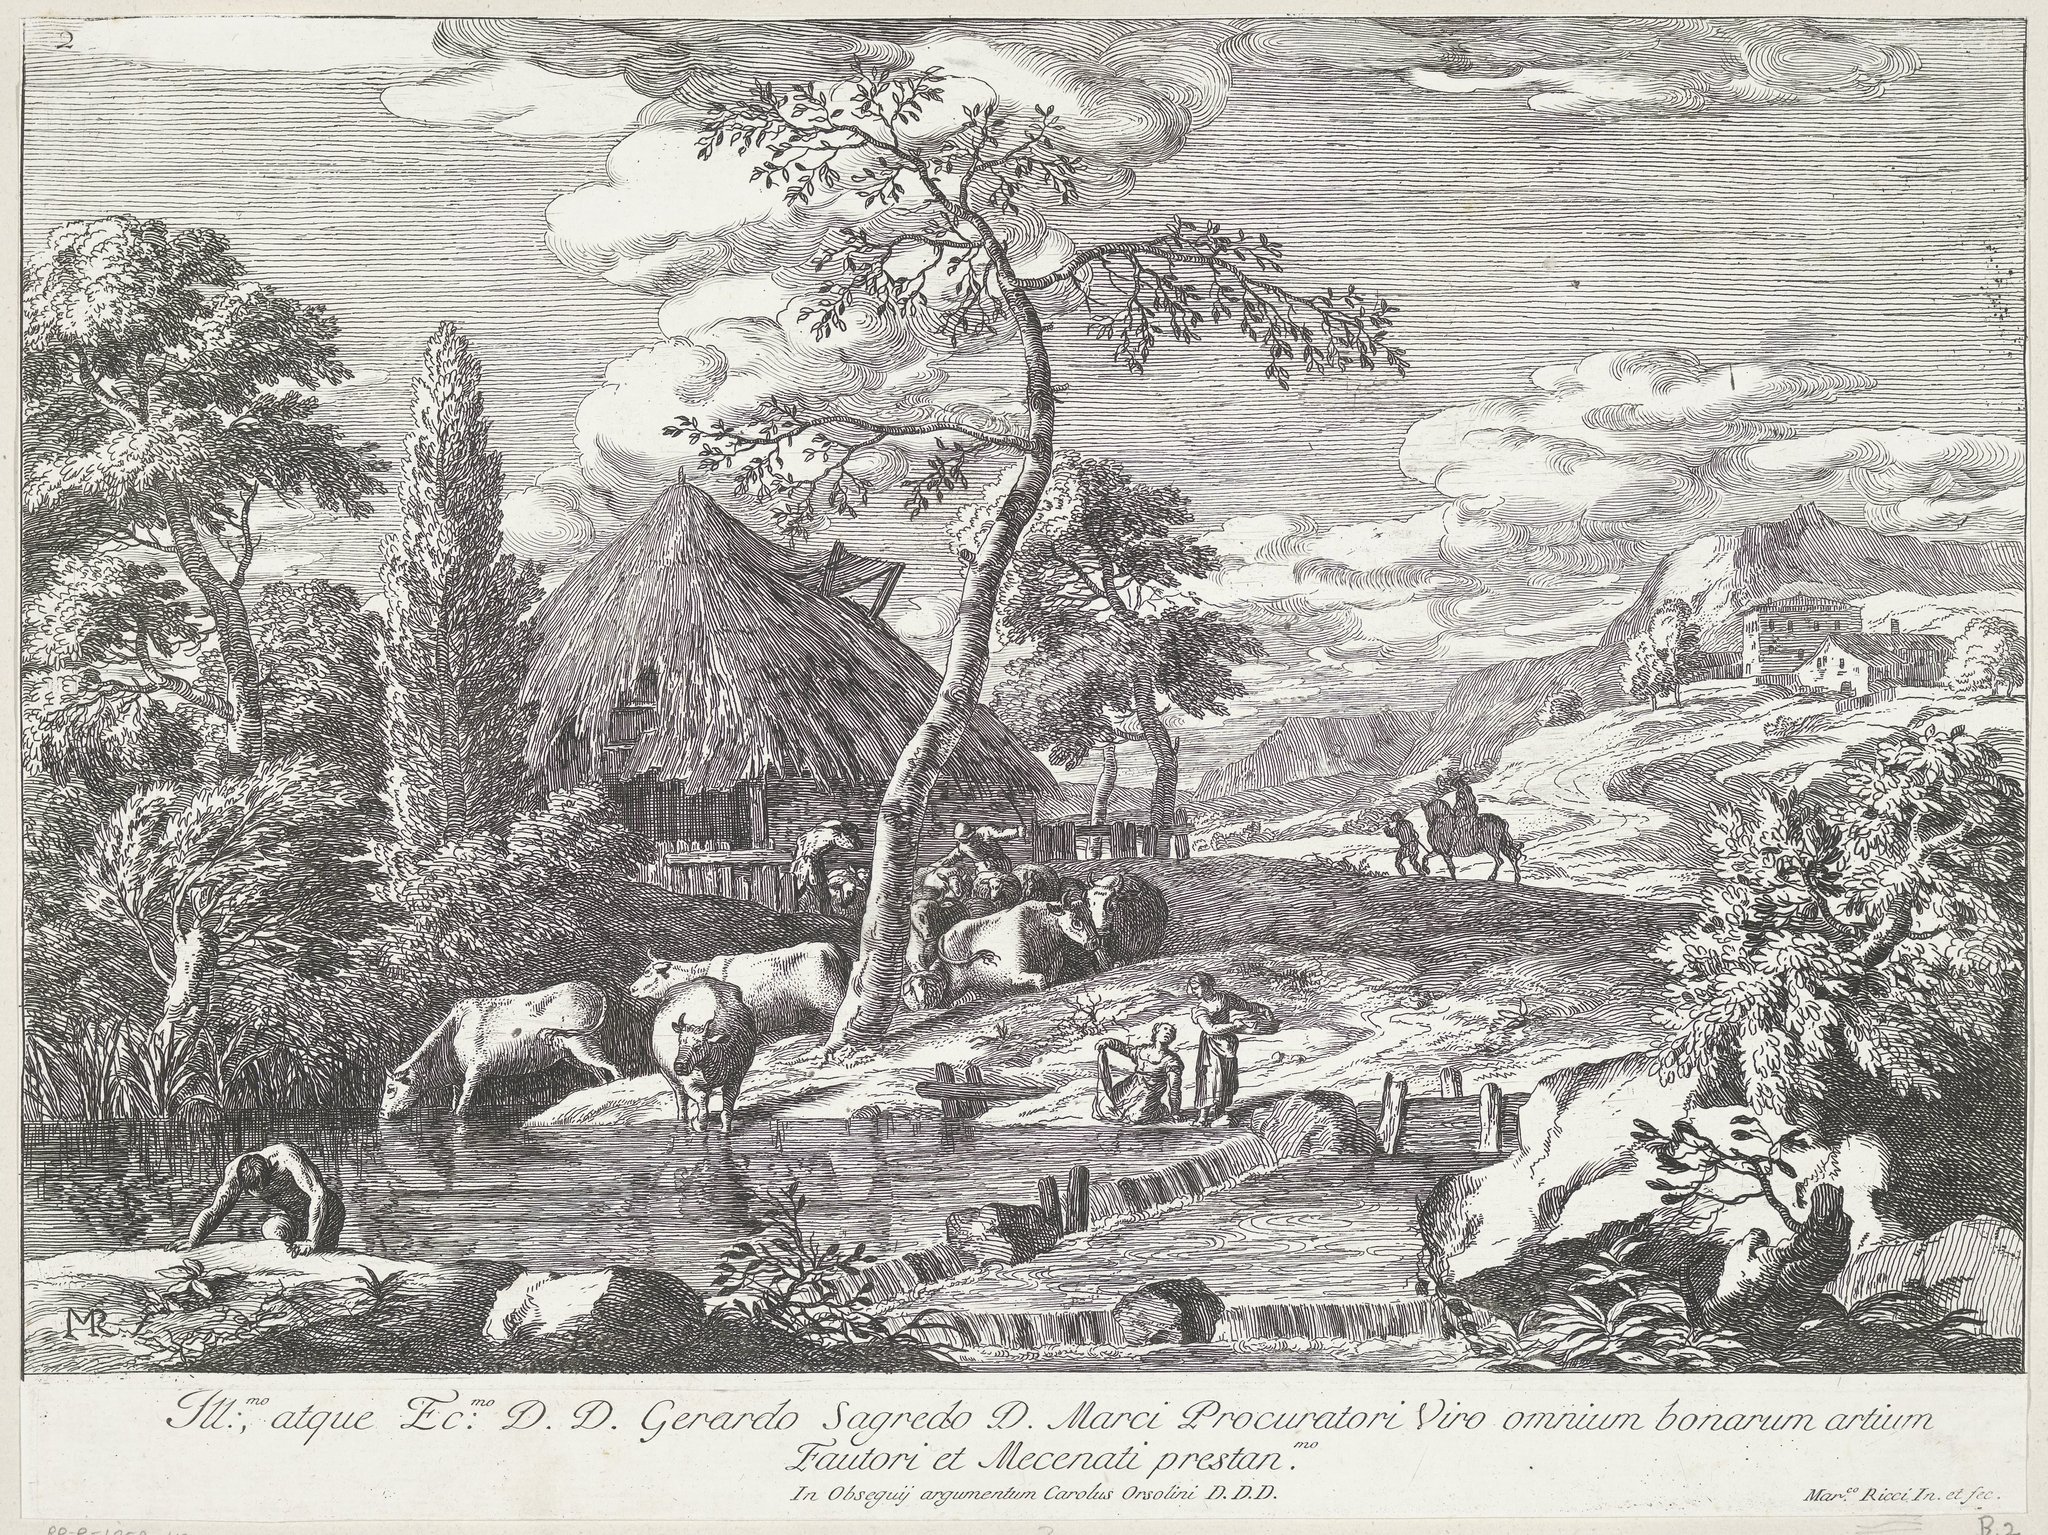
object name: print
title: Boerderij en kudde bij een rivier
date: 1730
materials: paper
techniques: etching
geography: italy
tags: river, herding, herdsman, herdswoman, shepherd, shepherdess, cowherd, etc., farm or solitary house in landscape, herd, flock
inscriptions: collector's mark: Lugt 2228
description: Deze prent maakt deel uit van een reeks van twintig prenten door Marco Ricci. De prenten zijn na de dood van Ricci in 1730 gebundeld door Carlo Orsolini en voorzien van een titelprent. Een getekende voorstudie voor deze prent wordt bewaard in Windsor Castle te Windsor (inv. nr. 01142).